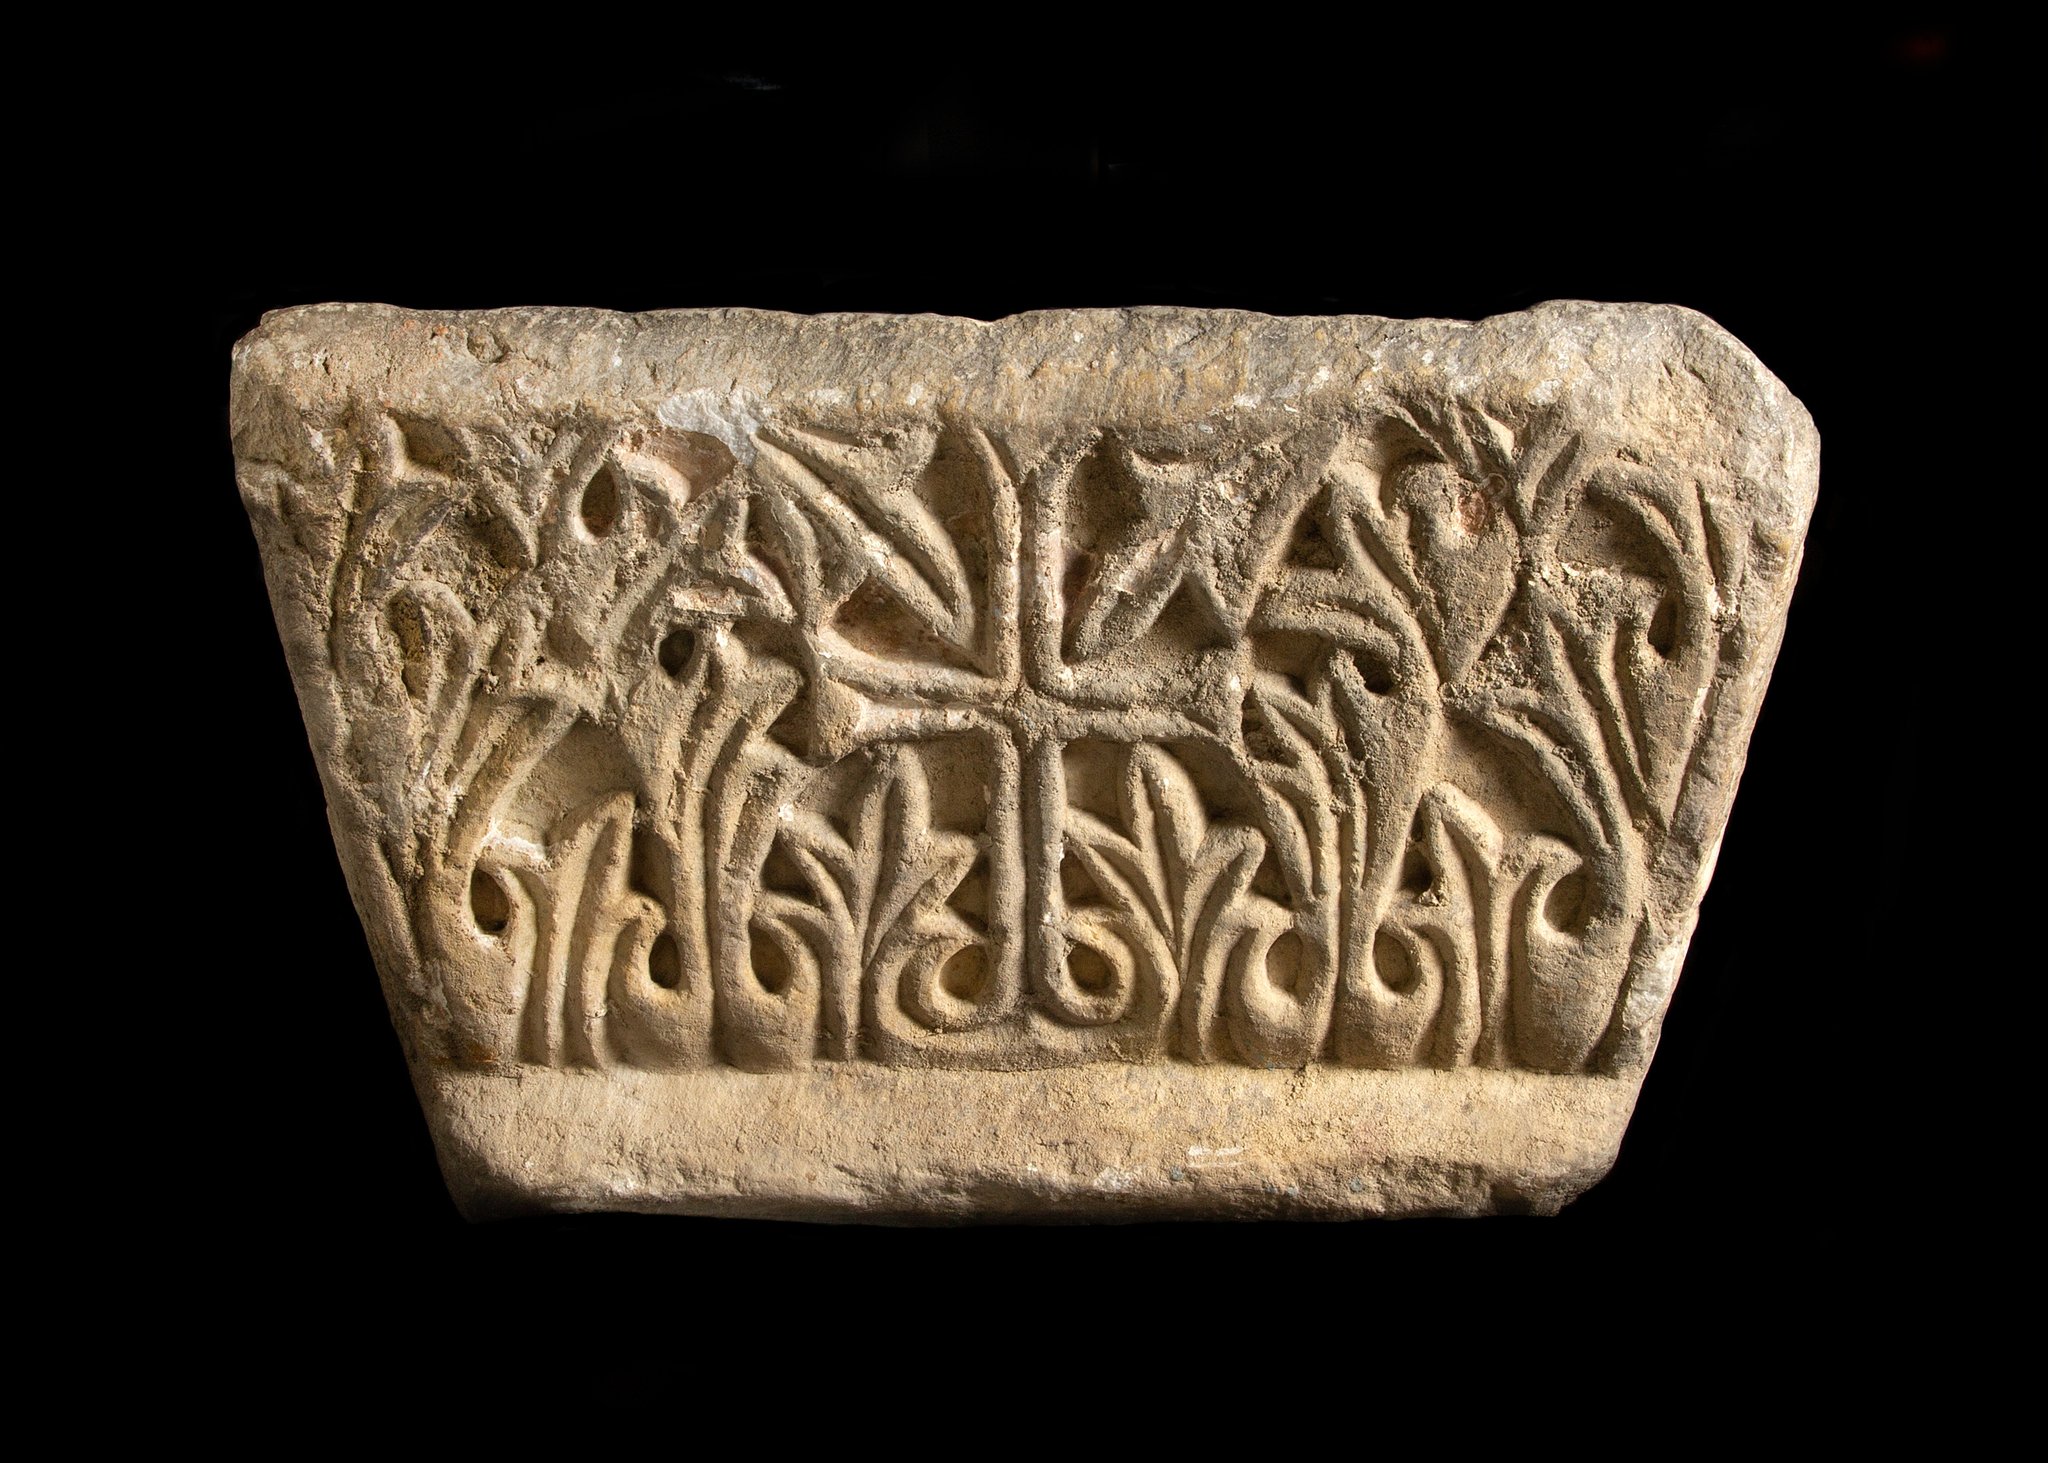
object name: abacus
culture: byzantine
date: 401-500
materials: marble